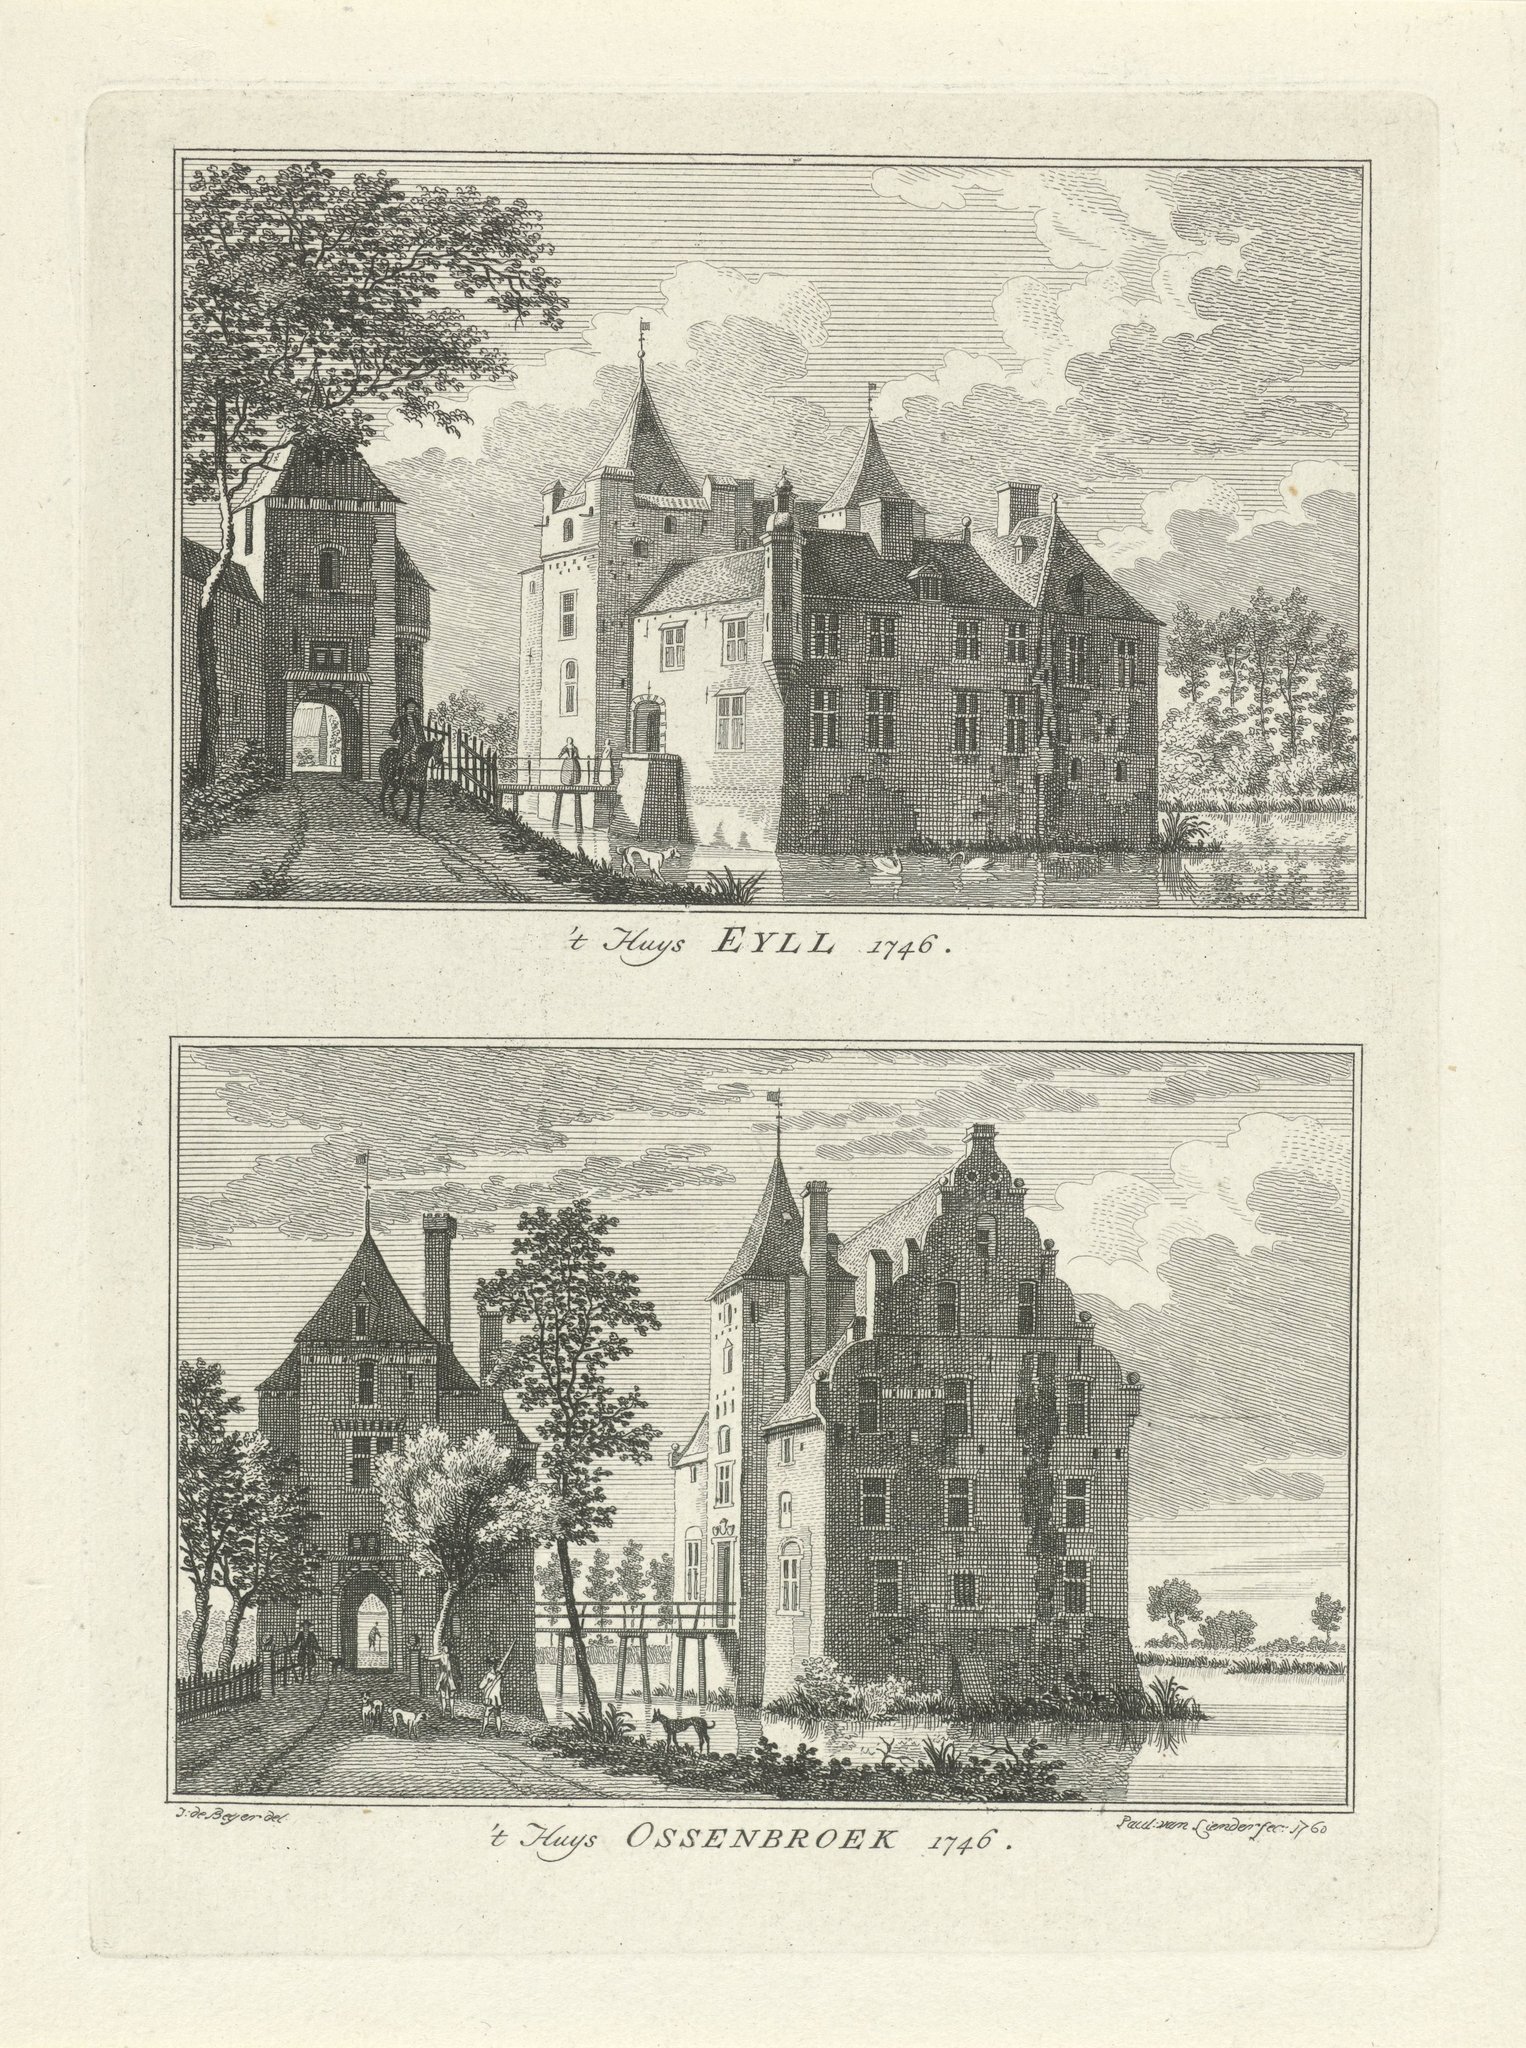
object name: print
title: Dorps- en stadsgezichten te Kleef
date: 1760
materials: paper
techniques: etching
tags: landscape with tower or castle, cleves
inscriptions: collector's mark: Lugt 240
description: Twee voorstellingen van één plaat. Gezicht op Kasteel Eyll (boven) en Kasteel Ossenbroek (onder) bij Kleef, Duitsland. De prent maakt deel uit van een 100-delige serie met gezichten op dorpen en steden te Kleef.